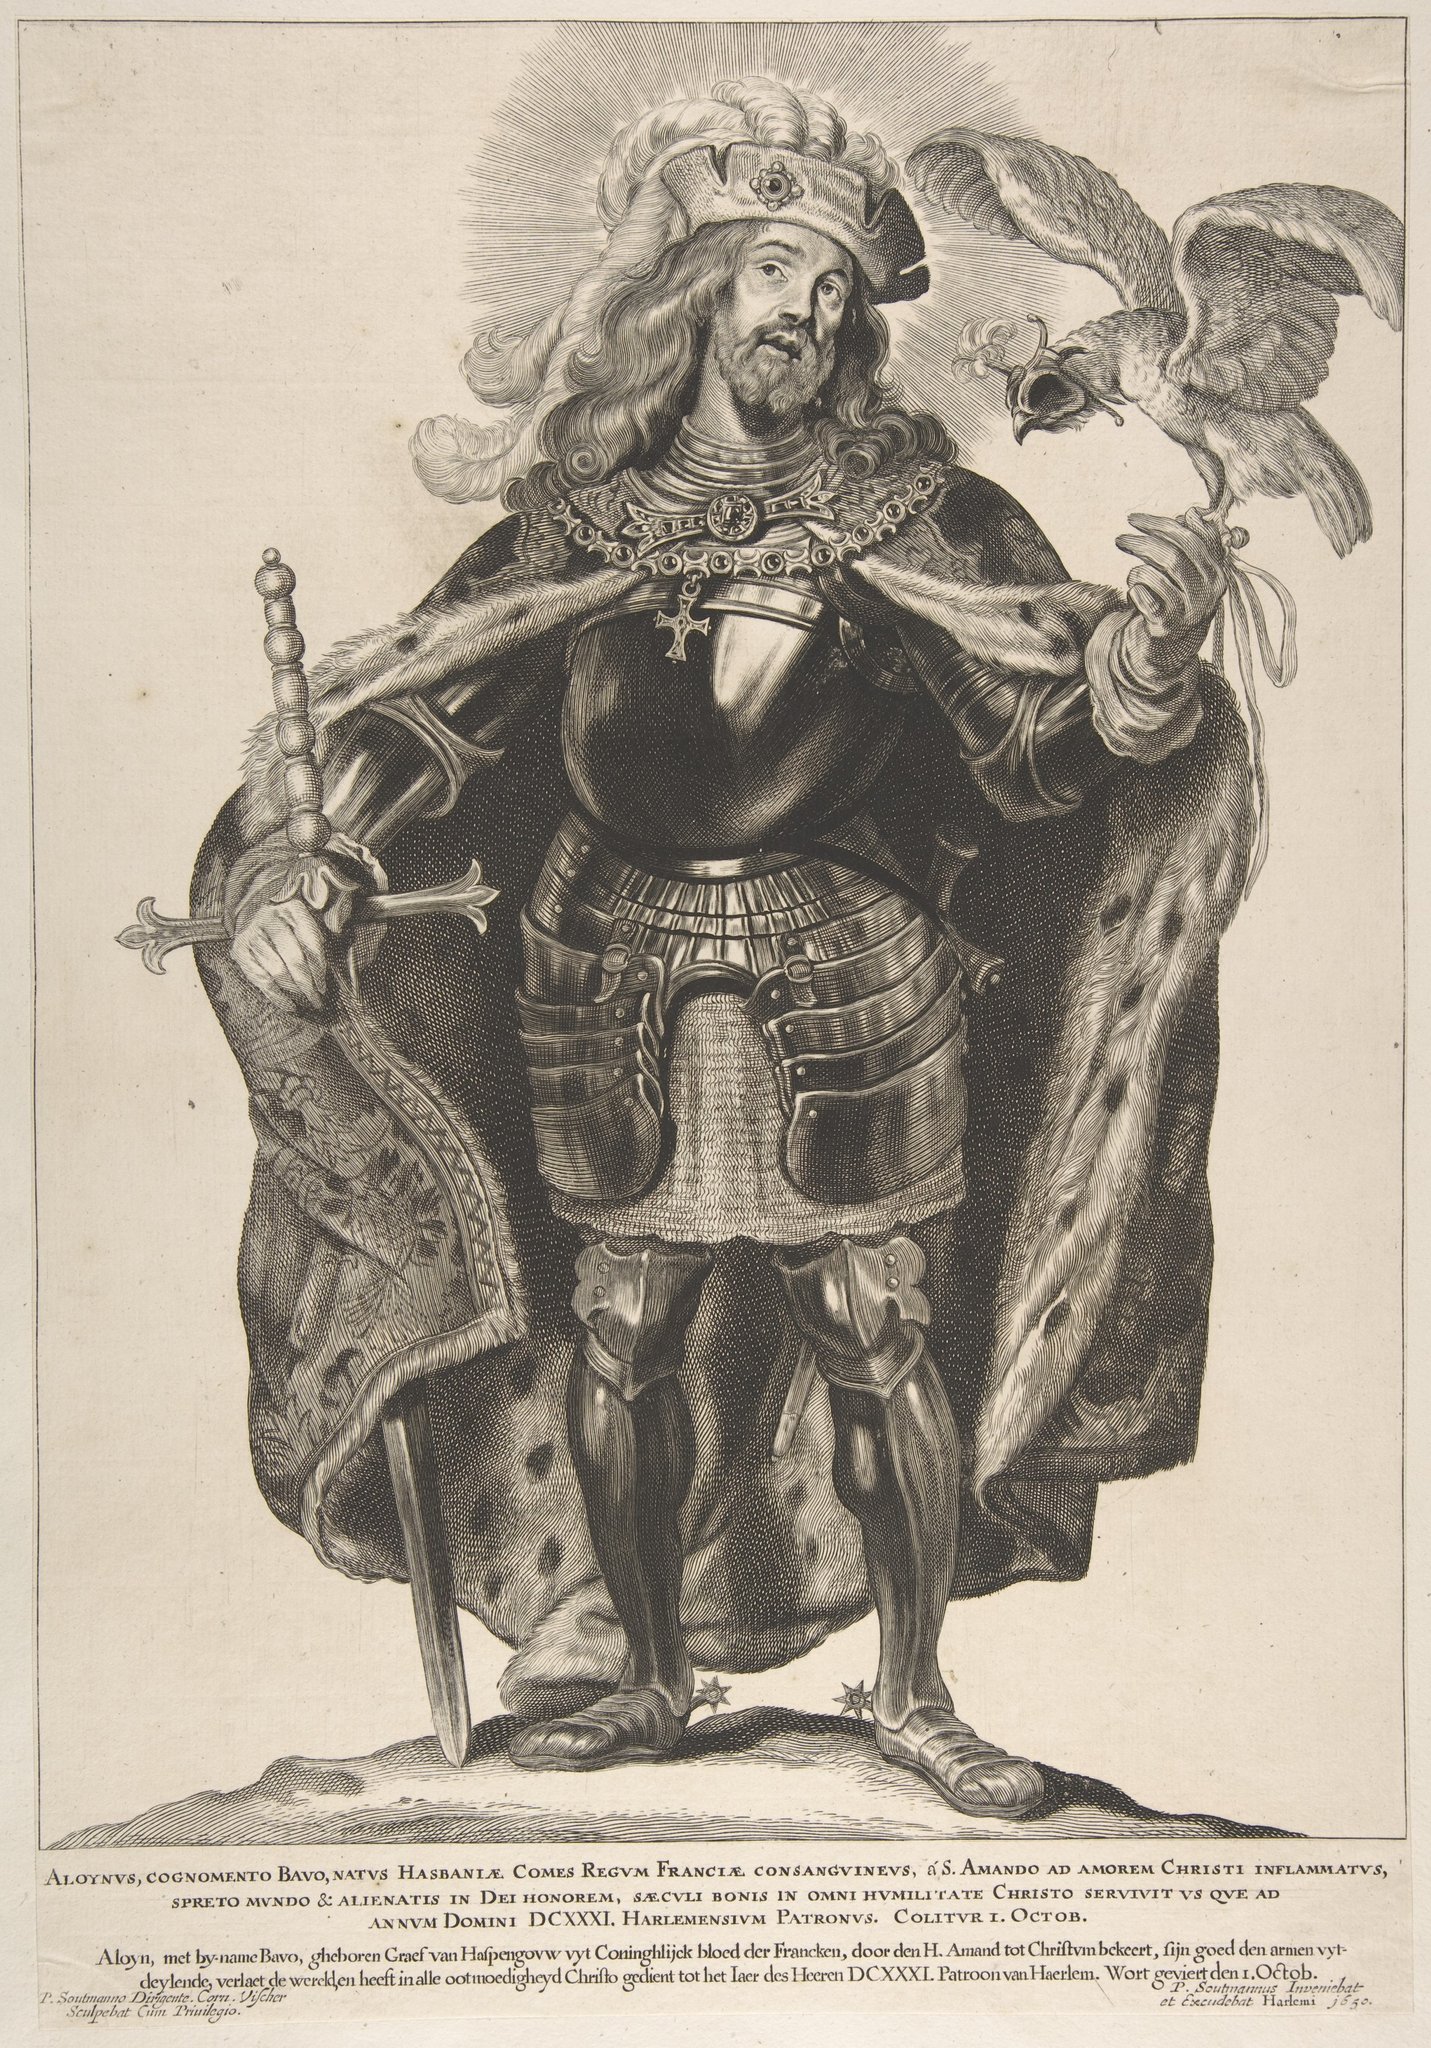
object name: print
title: St. Bavo, from the series Saints of North and South Netherlands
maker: pieter soutman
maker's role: artist and publisher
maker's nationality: dutch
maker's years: 1580-1657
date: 1650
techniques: engraving, etching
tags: birds,swords,saints